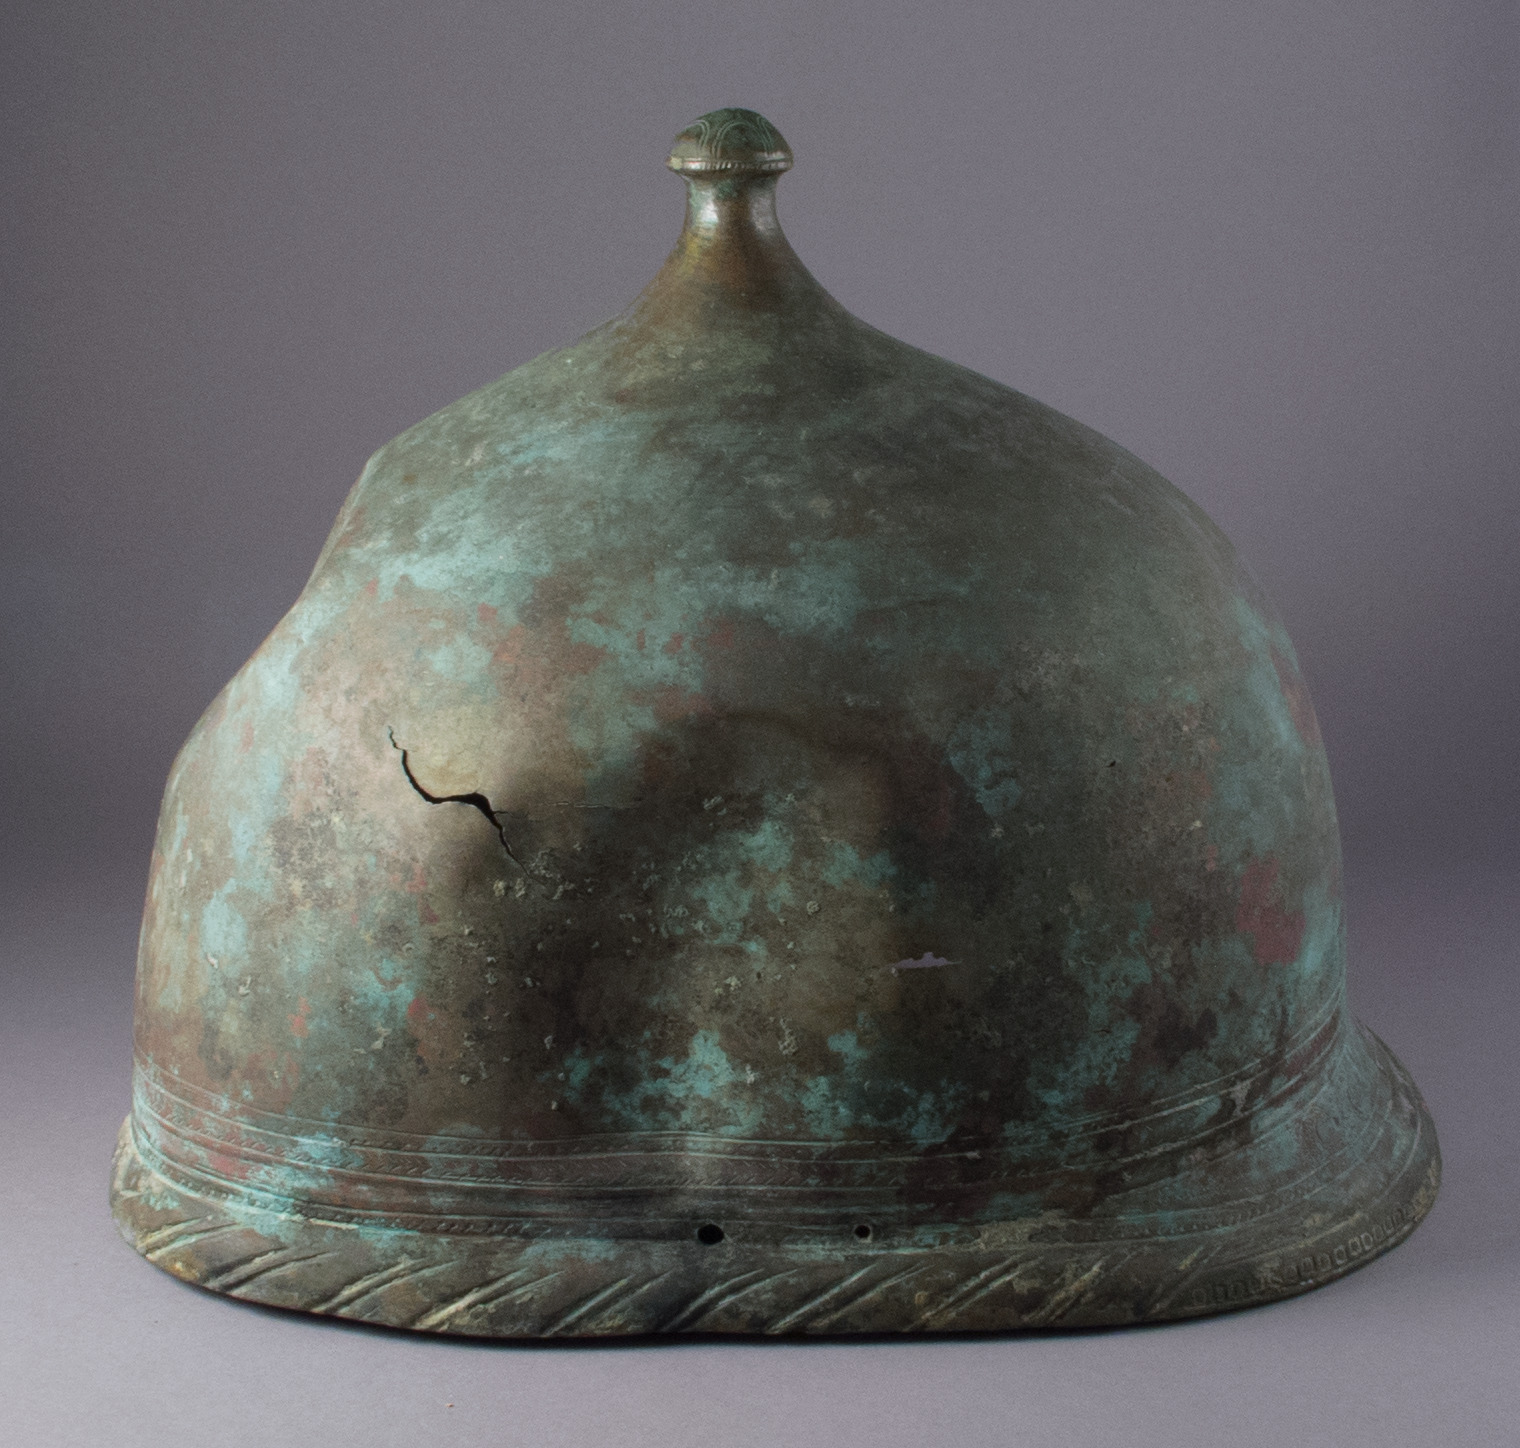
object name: helmet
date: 7000 BCE-330 CE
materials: bronze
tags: helmets